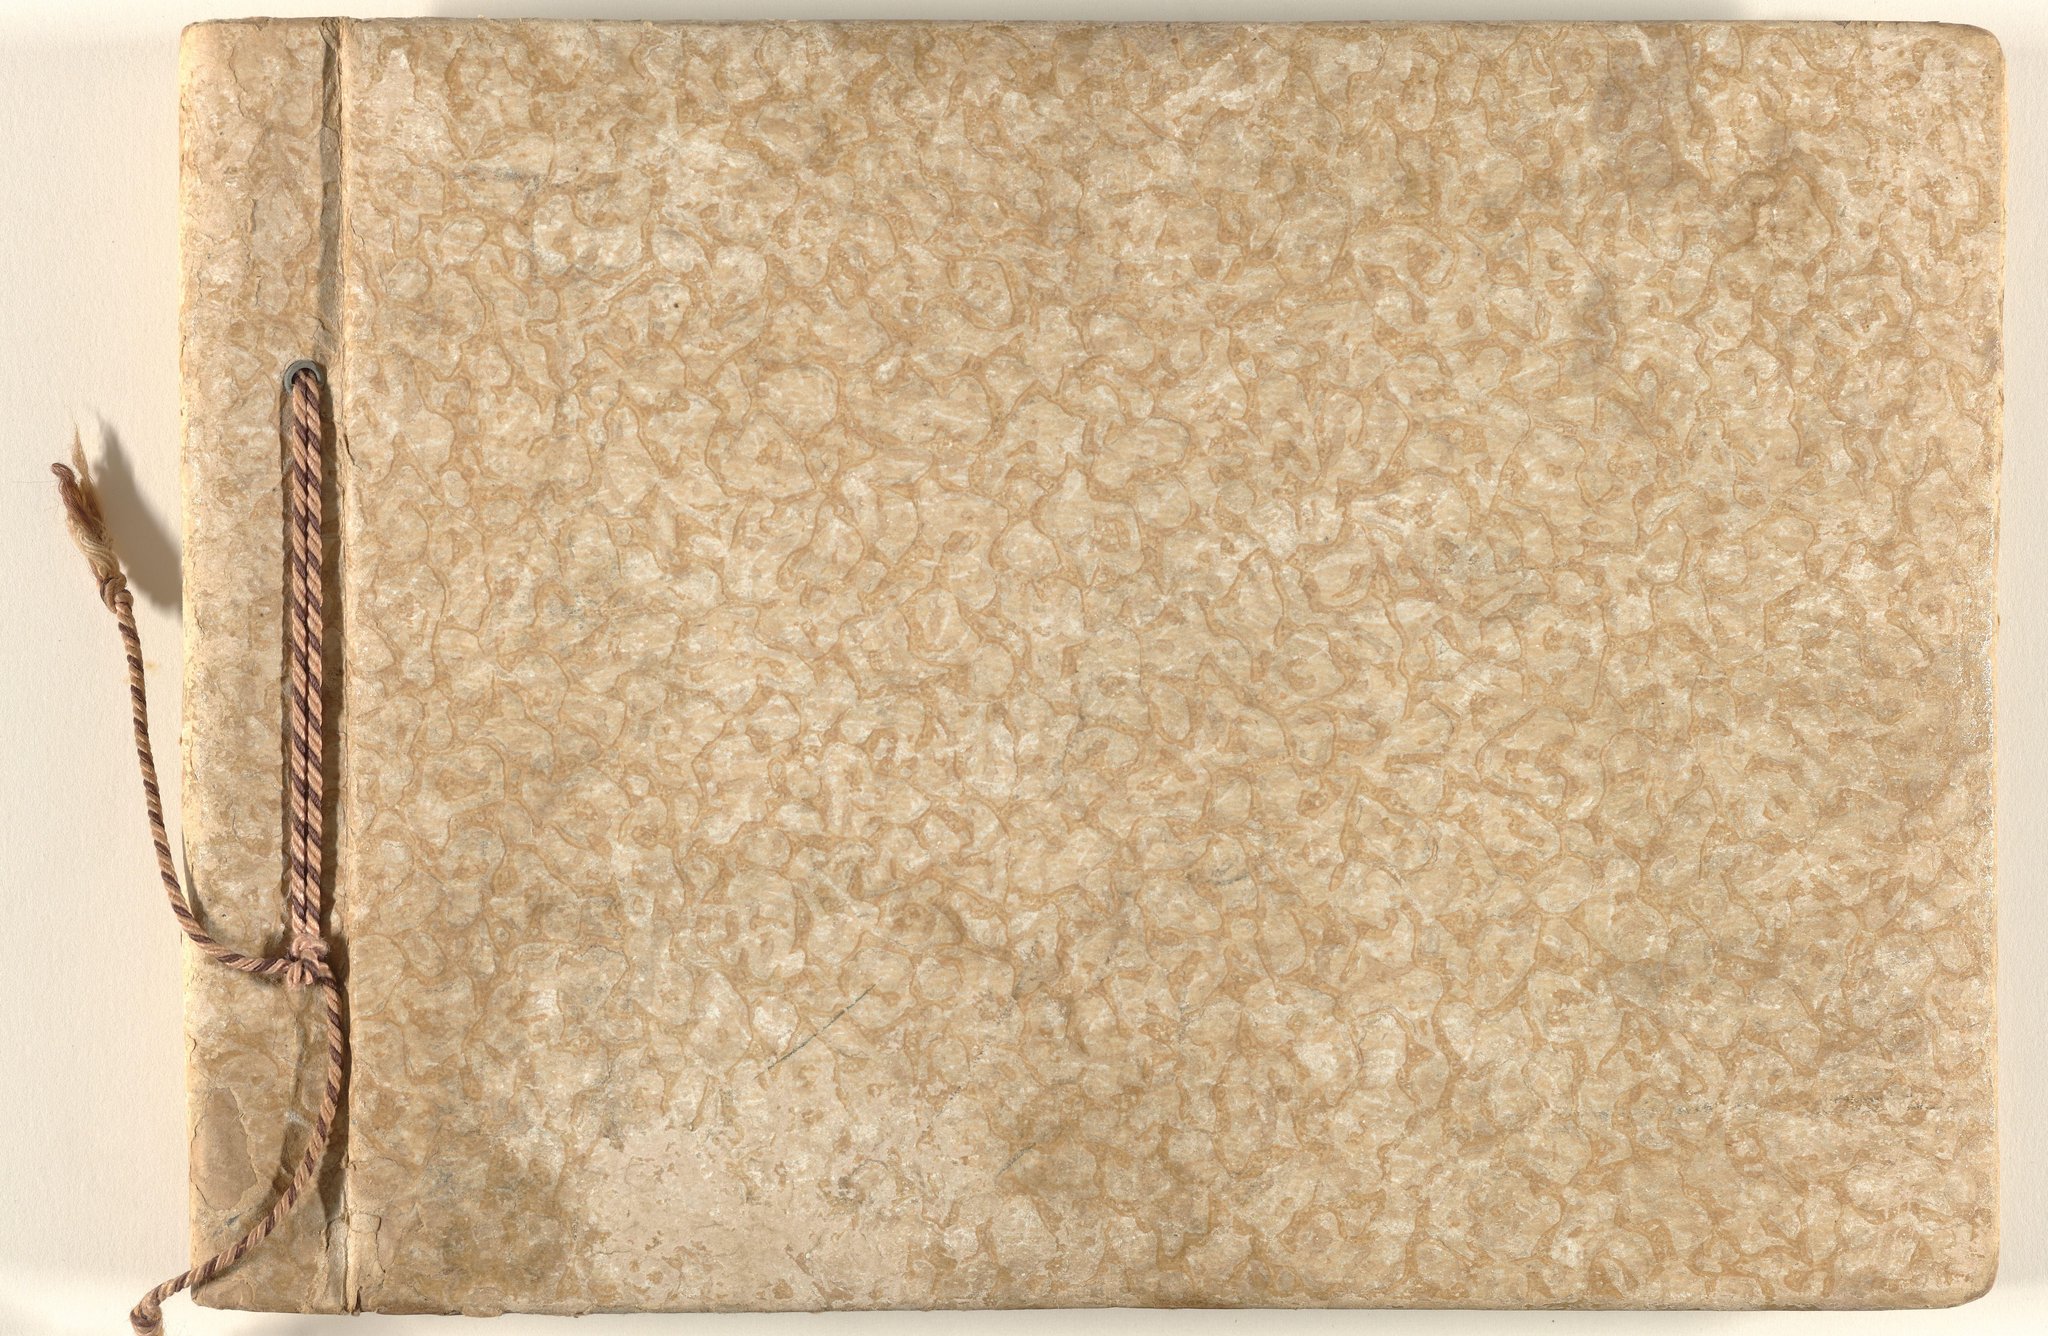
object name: photograph album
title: Album met foto's van de diensttijd van Nederlandse militairen in Indië, ca. 1946-1949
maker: Anonymous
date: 1946-1949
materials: paper, cardboard, plastic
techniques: gelatin silver print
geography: dutch east indies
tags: dutch east indies, the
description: Gerestaureerd fotoalbum met 20 bladen van bruin karton waarop in totaal 70 genummerde losse foto's zijn vastgezet met fotohoekjes (blad nr. 14 is leeg). Album in een band van karton bekleed met wit en lichtbruin kunststof (?) en ingebonden met een koordje. Hoofdzakelijk kiekjes van soldaten tijdens hun diensttijd in Indonesië ca. 1946-1949: materieel, een Indonesische kinderverzorgster (destijds 'baboe' genoemd), militaire acties en van een herdenking op een oorlogskerkhof in 1949 en de aldaar aanwezige oorlogsgraven. Verder ook enkele oudere familiefoto's: twee trouwfoto's en een foto van een jonge vrouw.